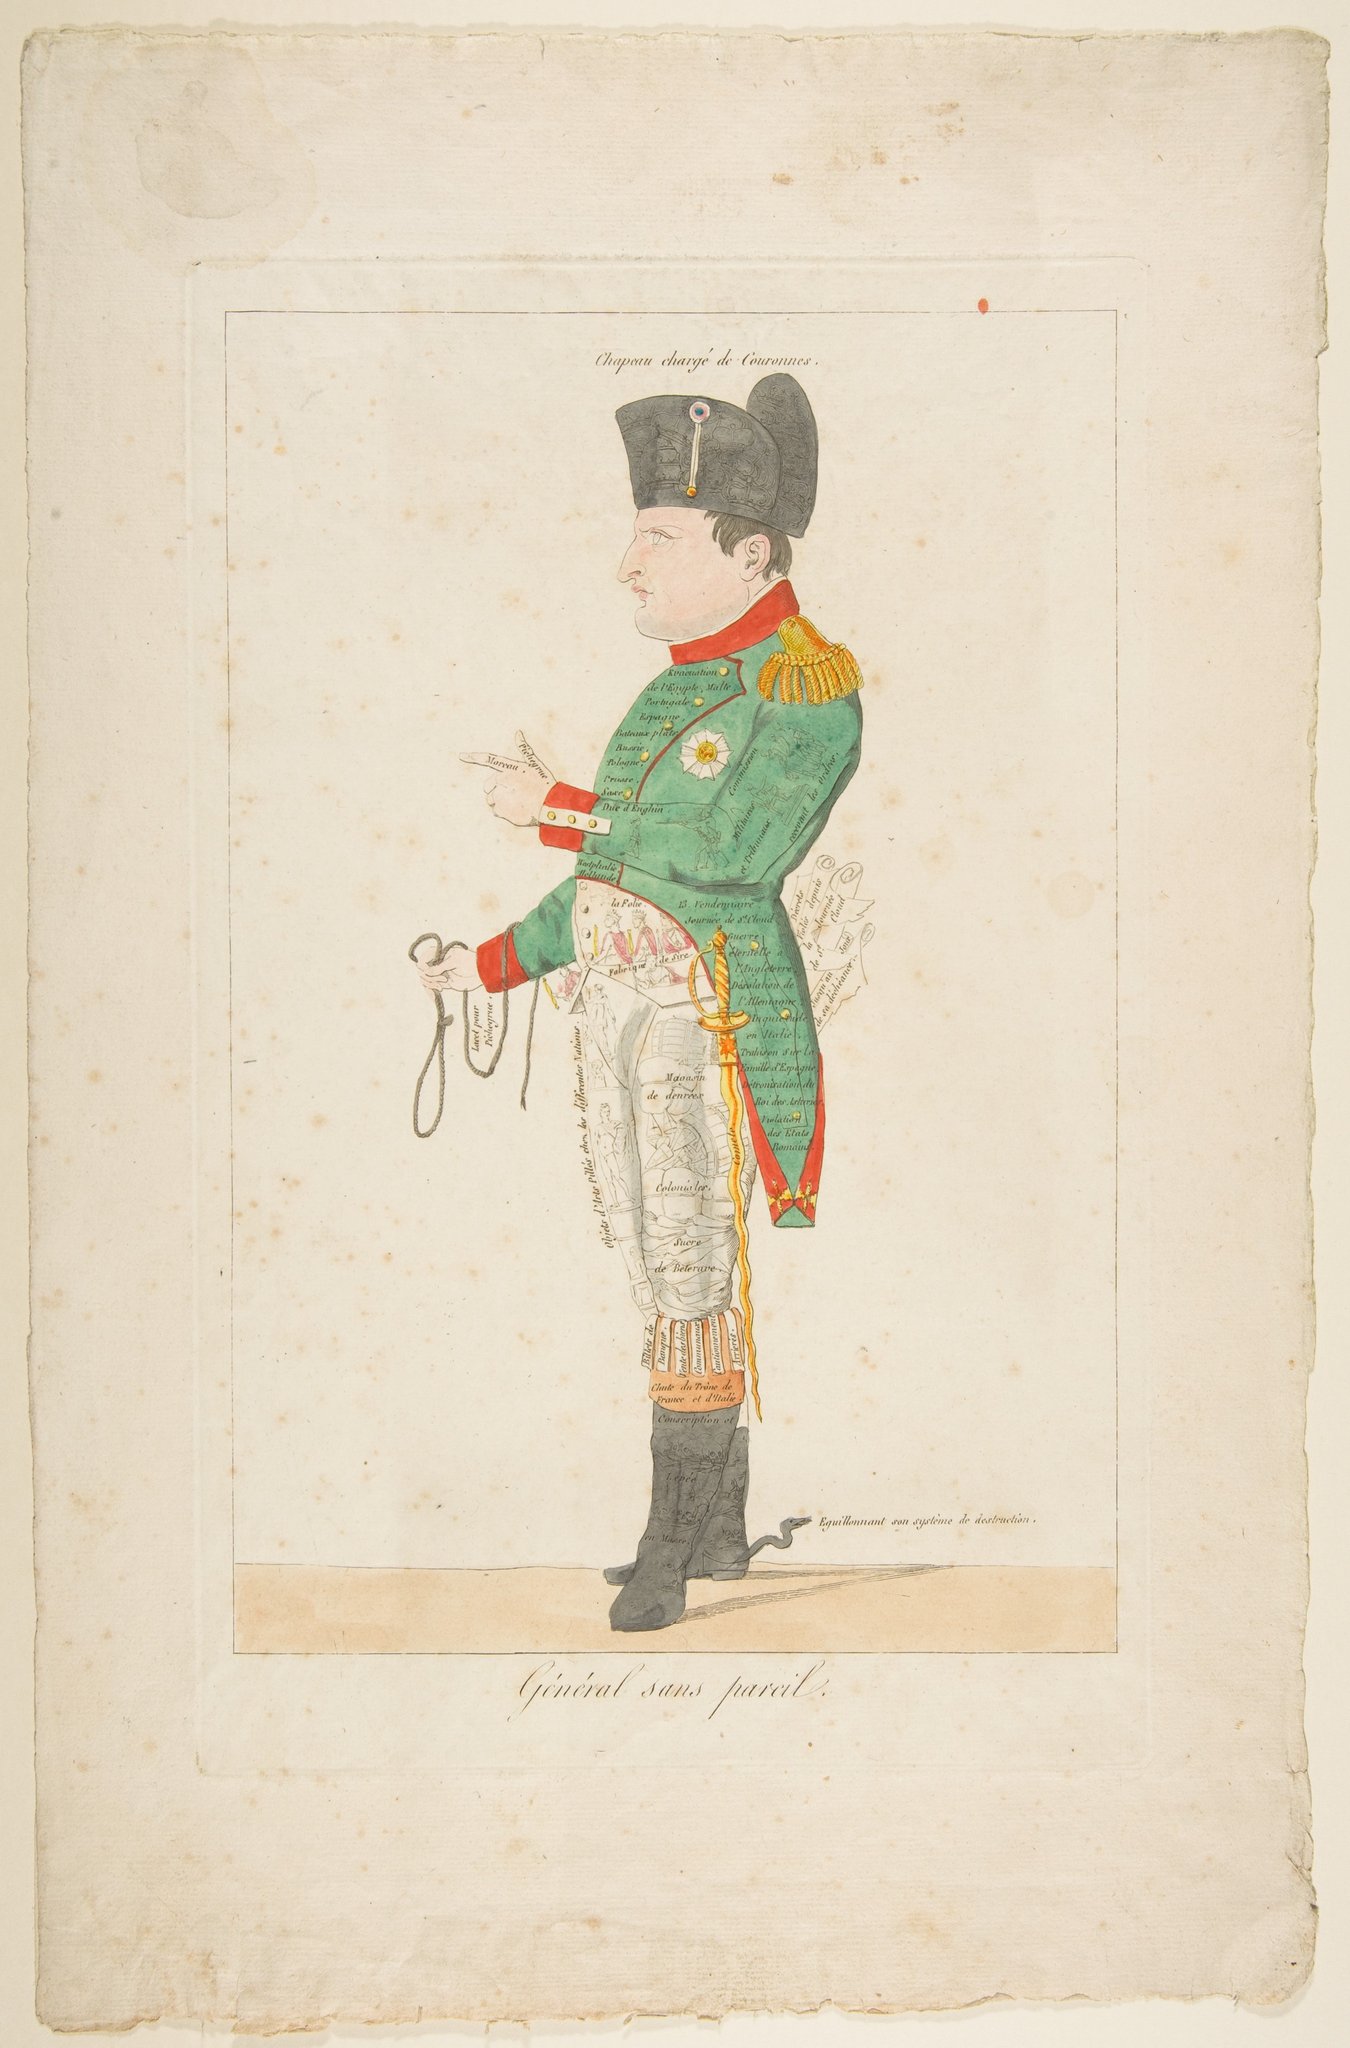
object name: print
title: Général sans pareil (The Peerless General)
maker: anonymous, french, 19th century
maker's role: artist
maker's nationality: french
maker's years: 1800-1900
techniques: etching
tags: napoleon i,men,caricature